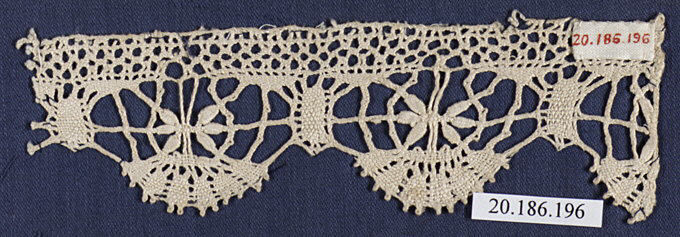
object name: edging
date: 1601-1700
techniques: lace